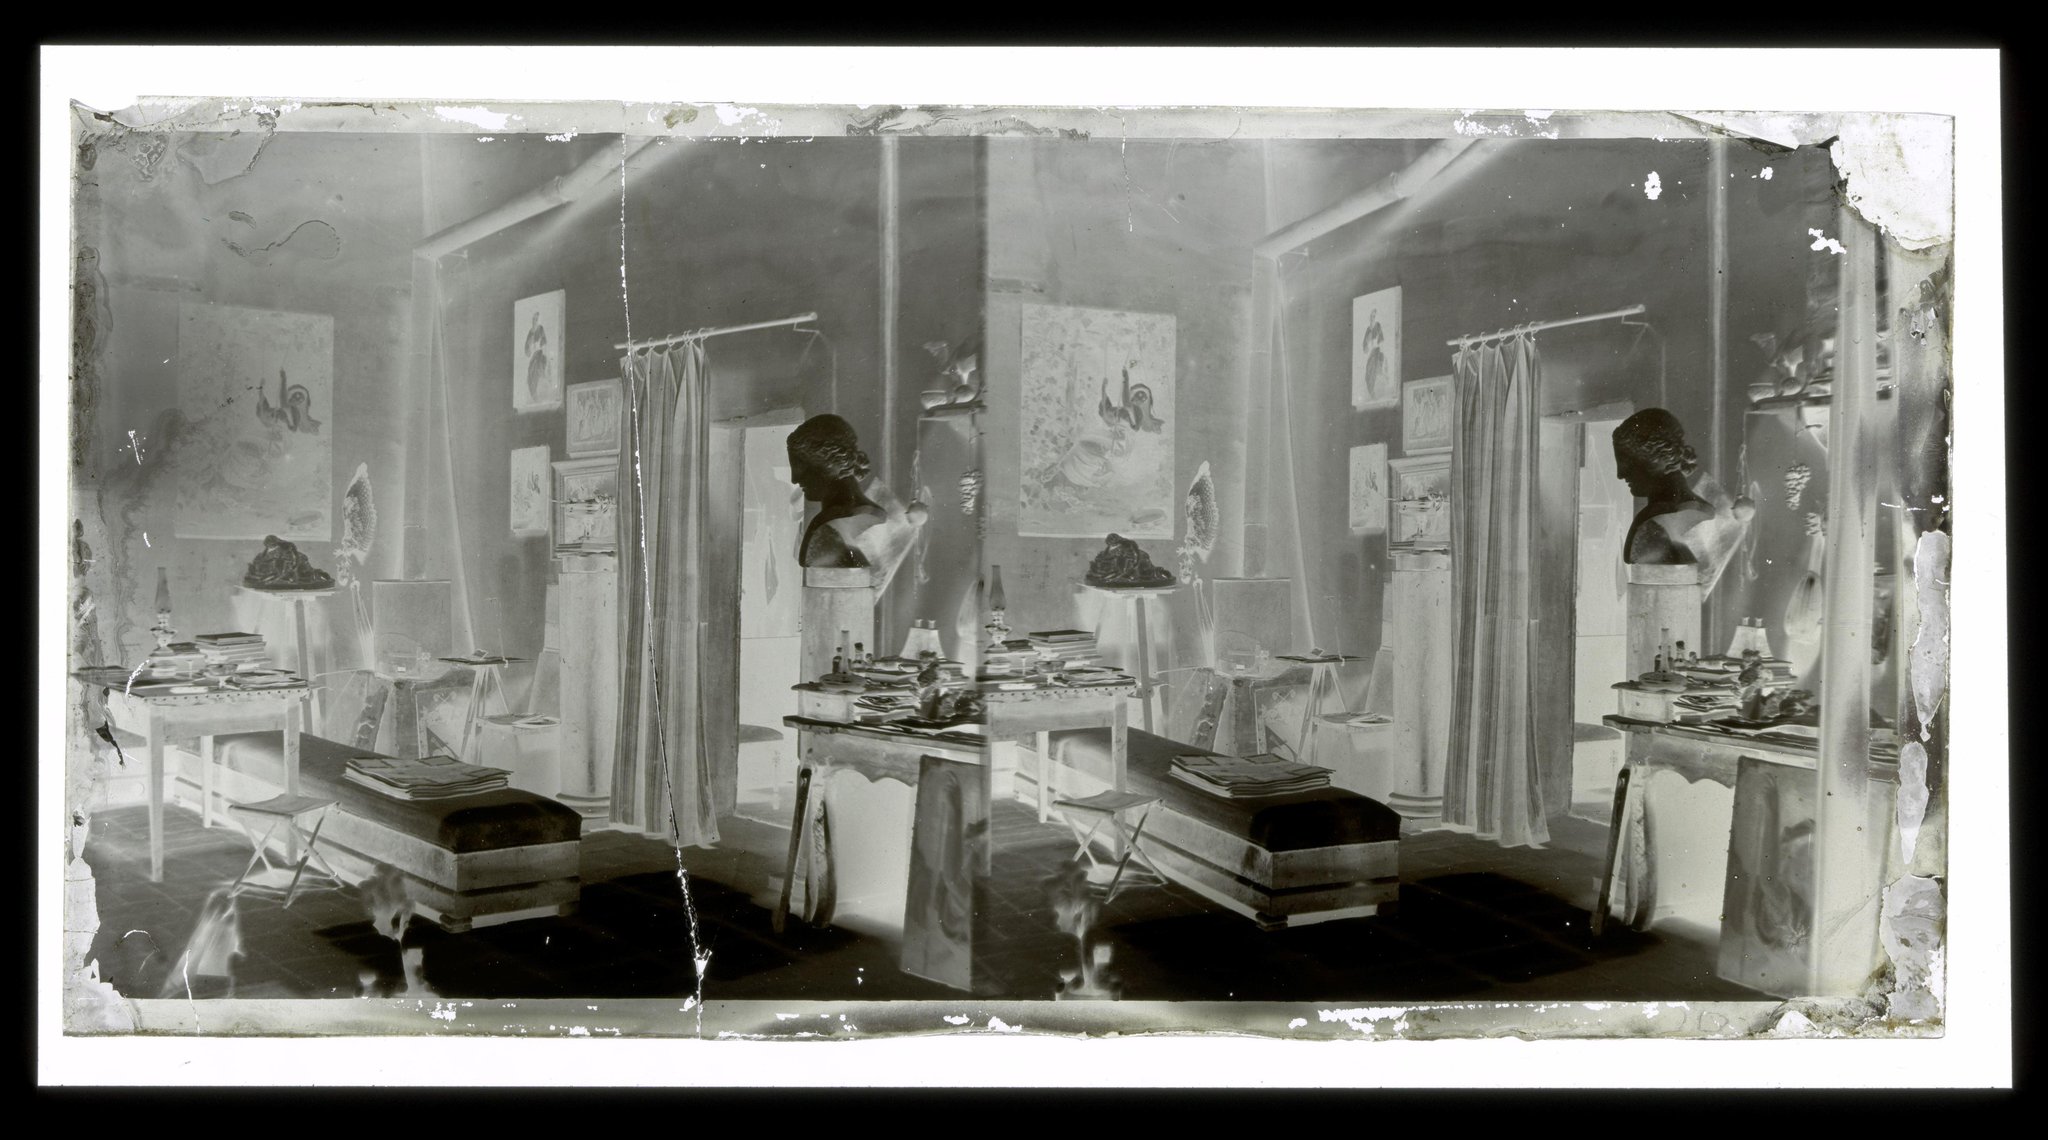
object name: glass negative stereograph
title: Interieur van het atelier van Laurens Lodewijk Kleijn in Rome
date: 1860-1862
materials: glass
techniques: collodion process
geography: rome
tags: workshop, studio of the artist (in general)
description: Onderdeel van een groep glasnegatieven uit de nalatenschap van de schilder Laurens Lodewijk Kleijn, met stillevens, portretten, zelfportretten en kunstreproducties.